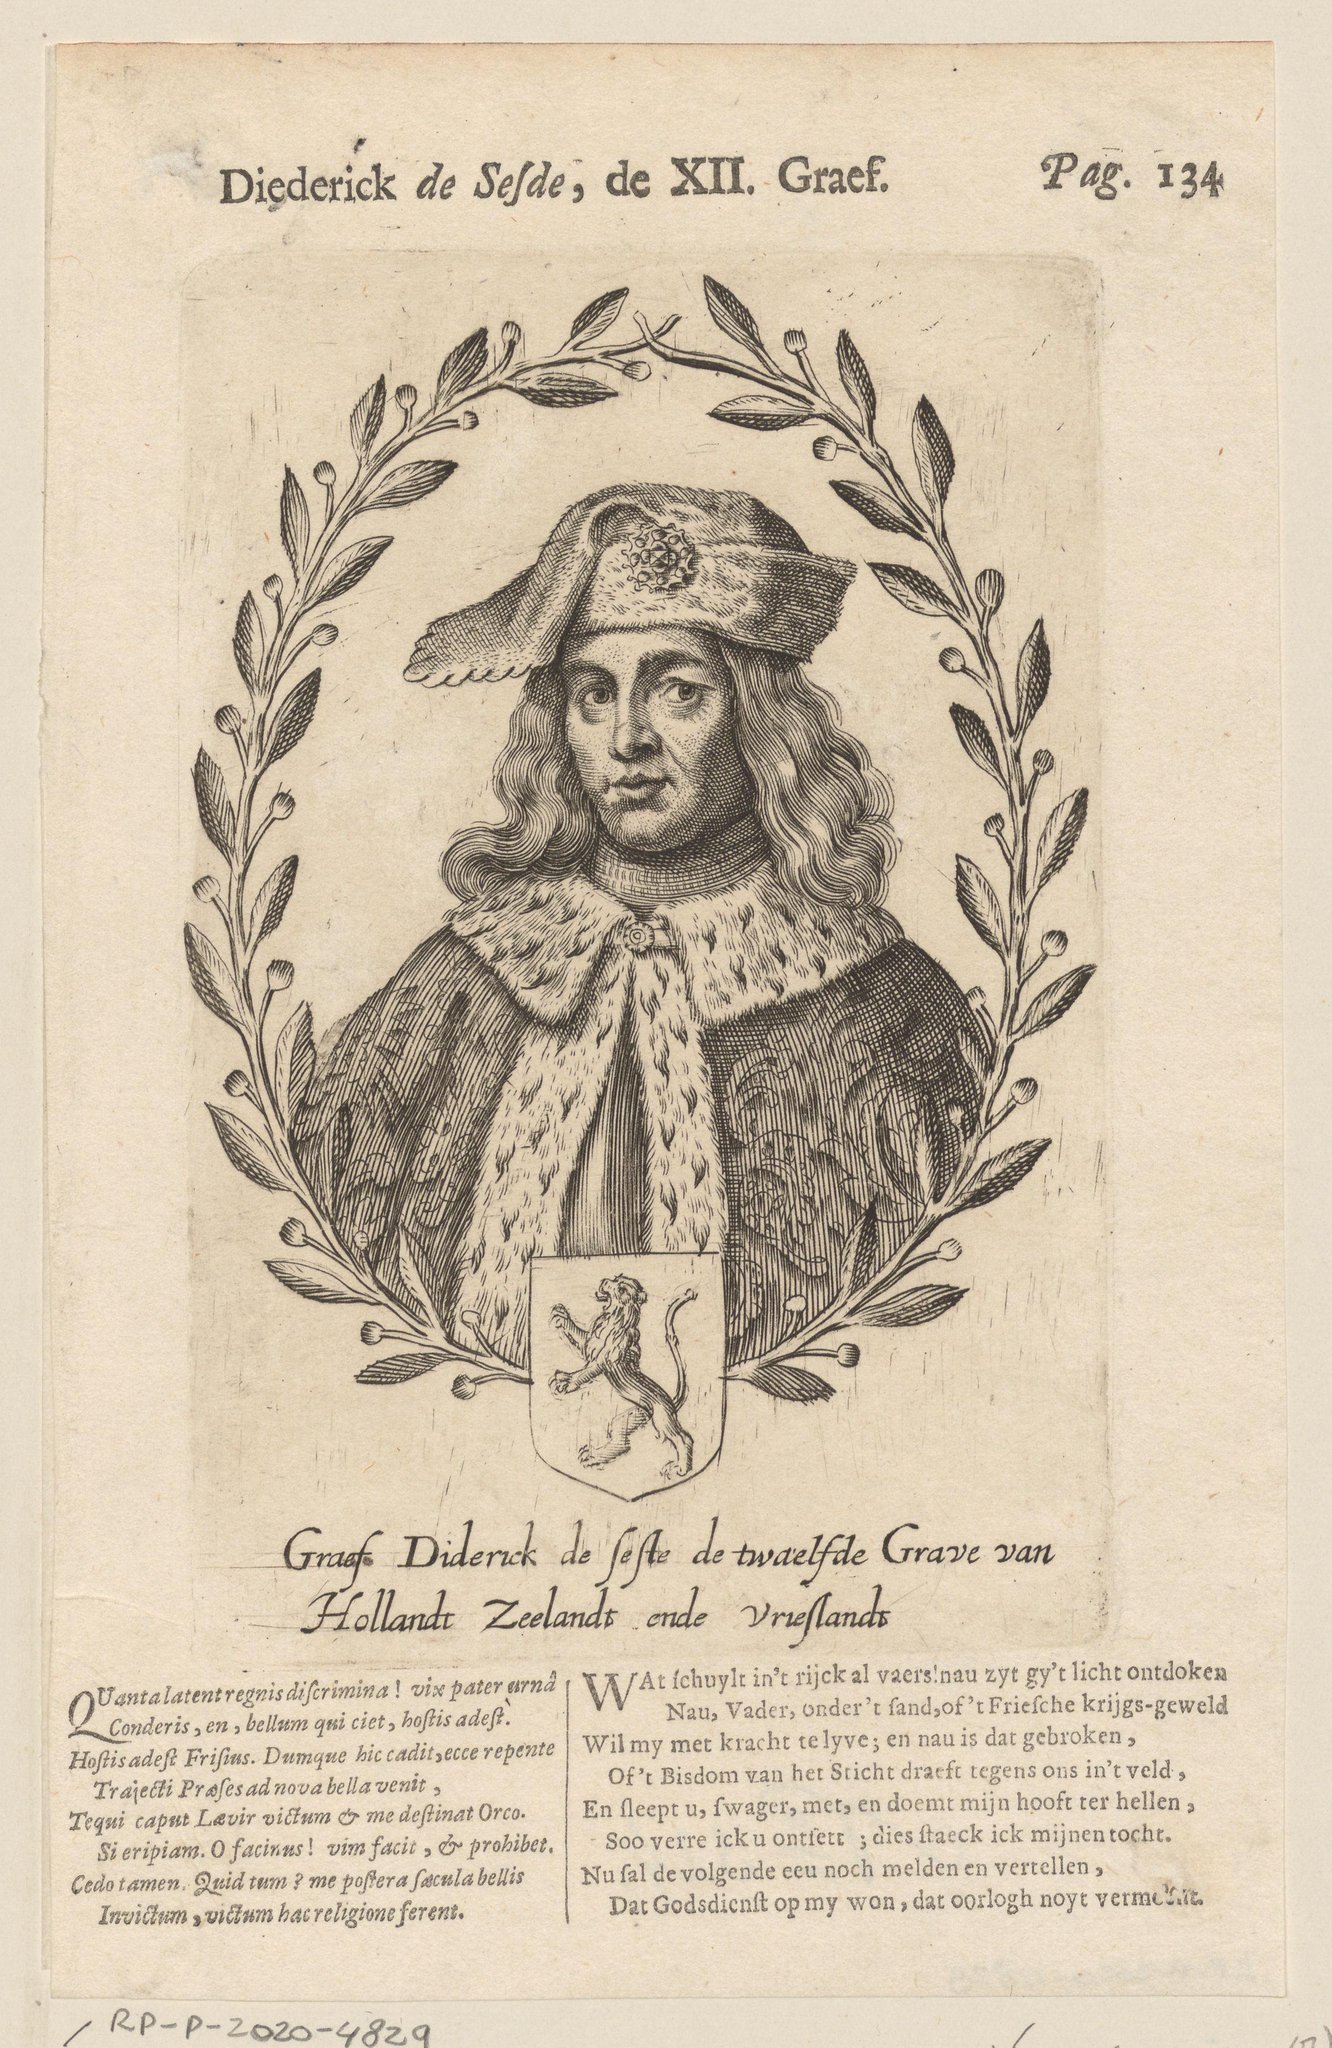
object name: print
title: Portret van Dirk VI, graaf van Holland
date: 1667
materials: paper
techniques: engraving, letterpress printing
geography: the hague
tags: historical persons, head-gear: hat, ruler, sovereign, armorial bearing, heraldry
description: Prent uit: Scriverius, Petrus. Oude en nieuwe beschryvinge van Holland, Zeeland en Vriesland (...). Den Haag: Levijn van Dijck, 1667, dl. 1, p. 134.